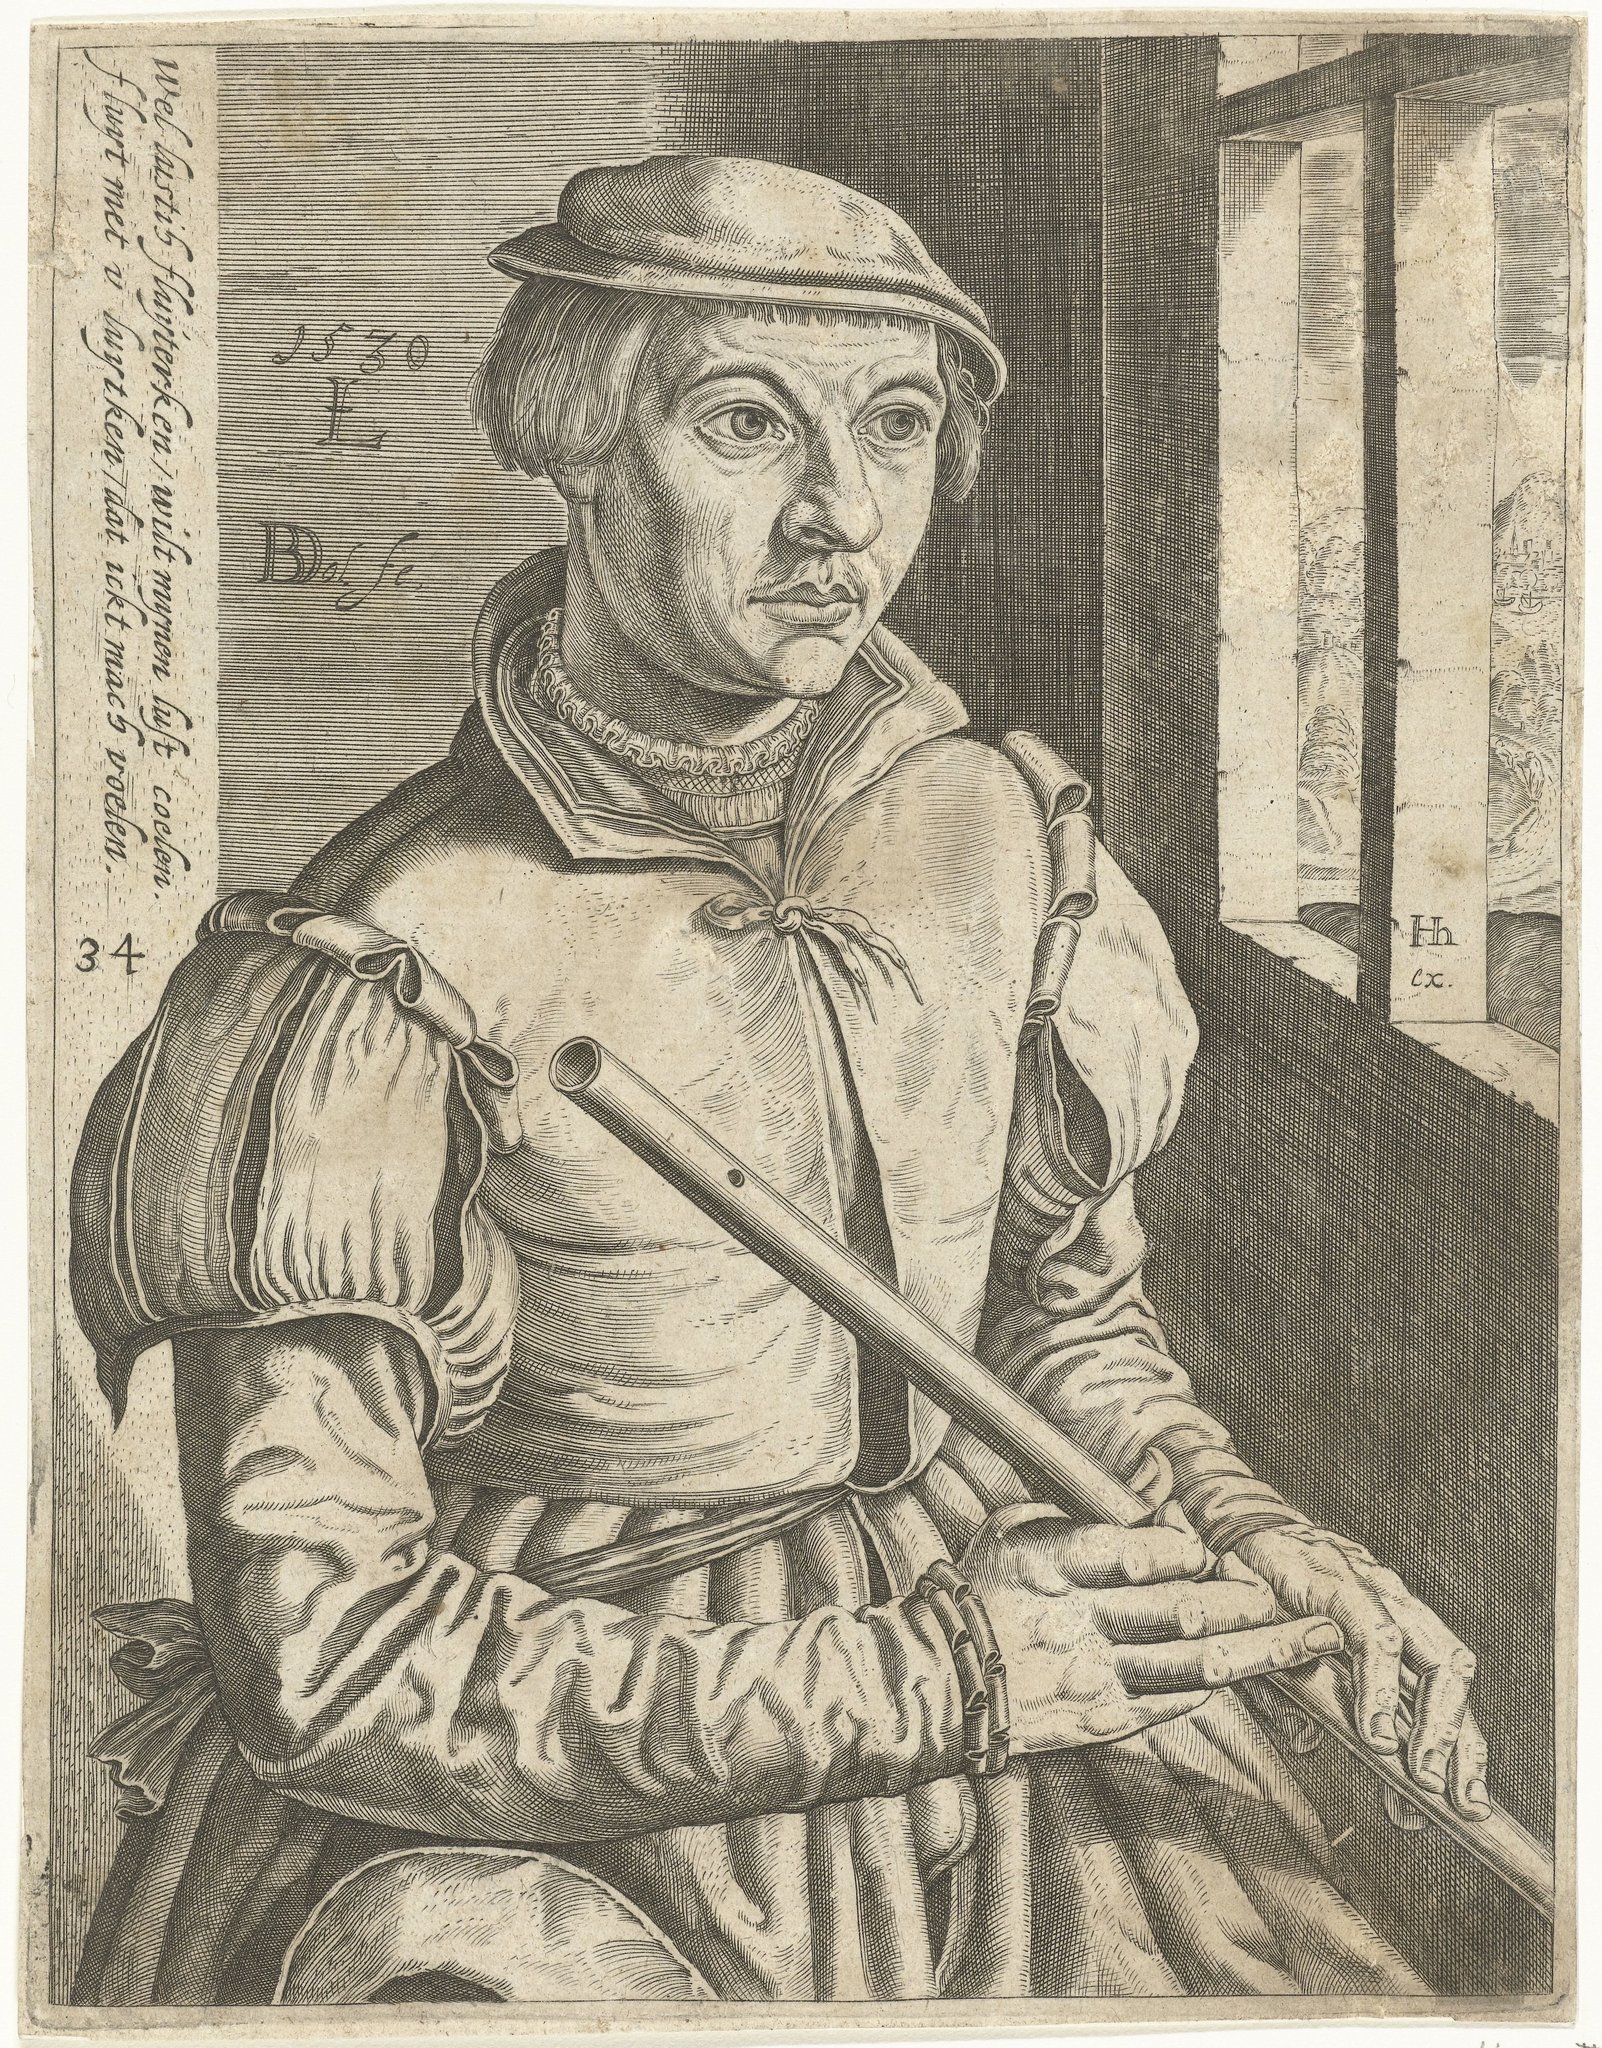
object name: print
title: De fluitist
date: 1589-1626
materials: paper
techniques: engraving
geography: leiden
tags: one person playing wind instrument, flute, aulos, tibia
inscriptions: poem: ‘Wellustich fluiterken ... Coelen/ fluyt ... voelen.’, collector's mark: Lugt 2228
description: Een fluitist zit voor een open raam met uitzicht op de haven. Met een Nederlands vers links in de marge.